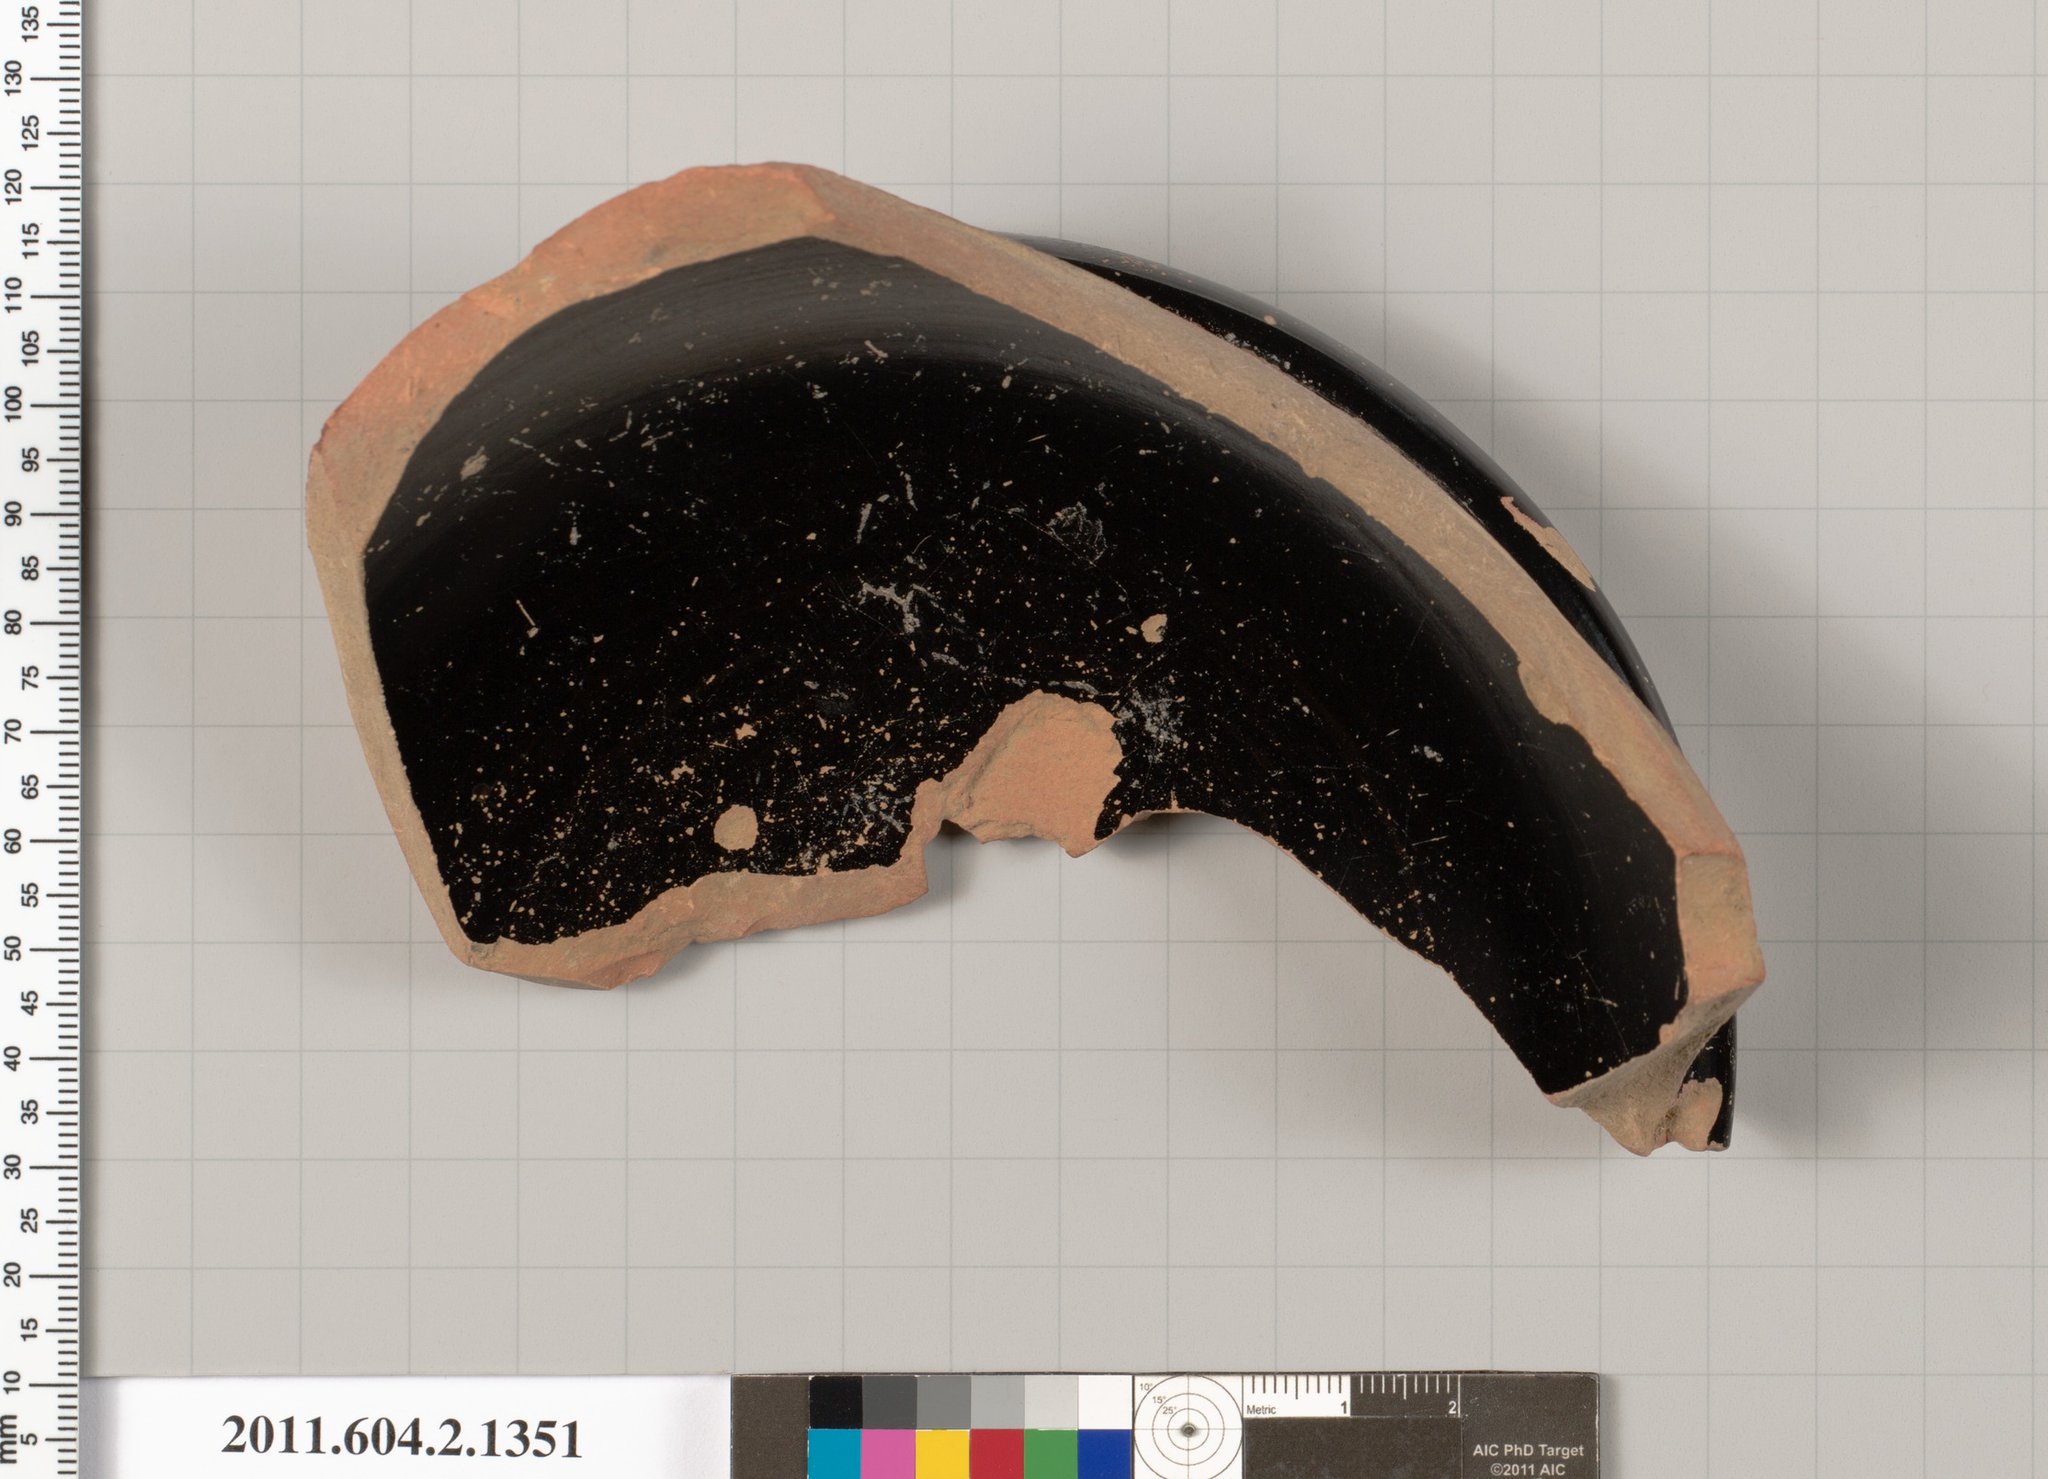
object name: skyphos fragment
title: Terracotta fragment of a skyphos (deep drinking cup)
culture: greek, attic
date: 475-451 BCE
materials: terracotta